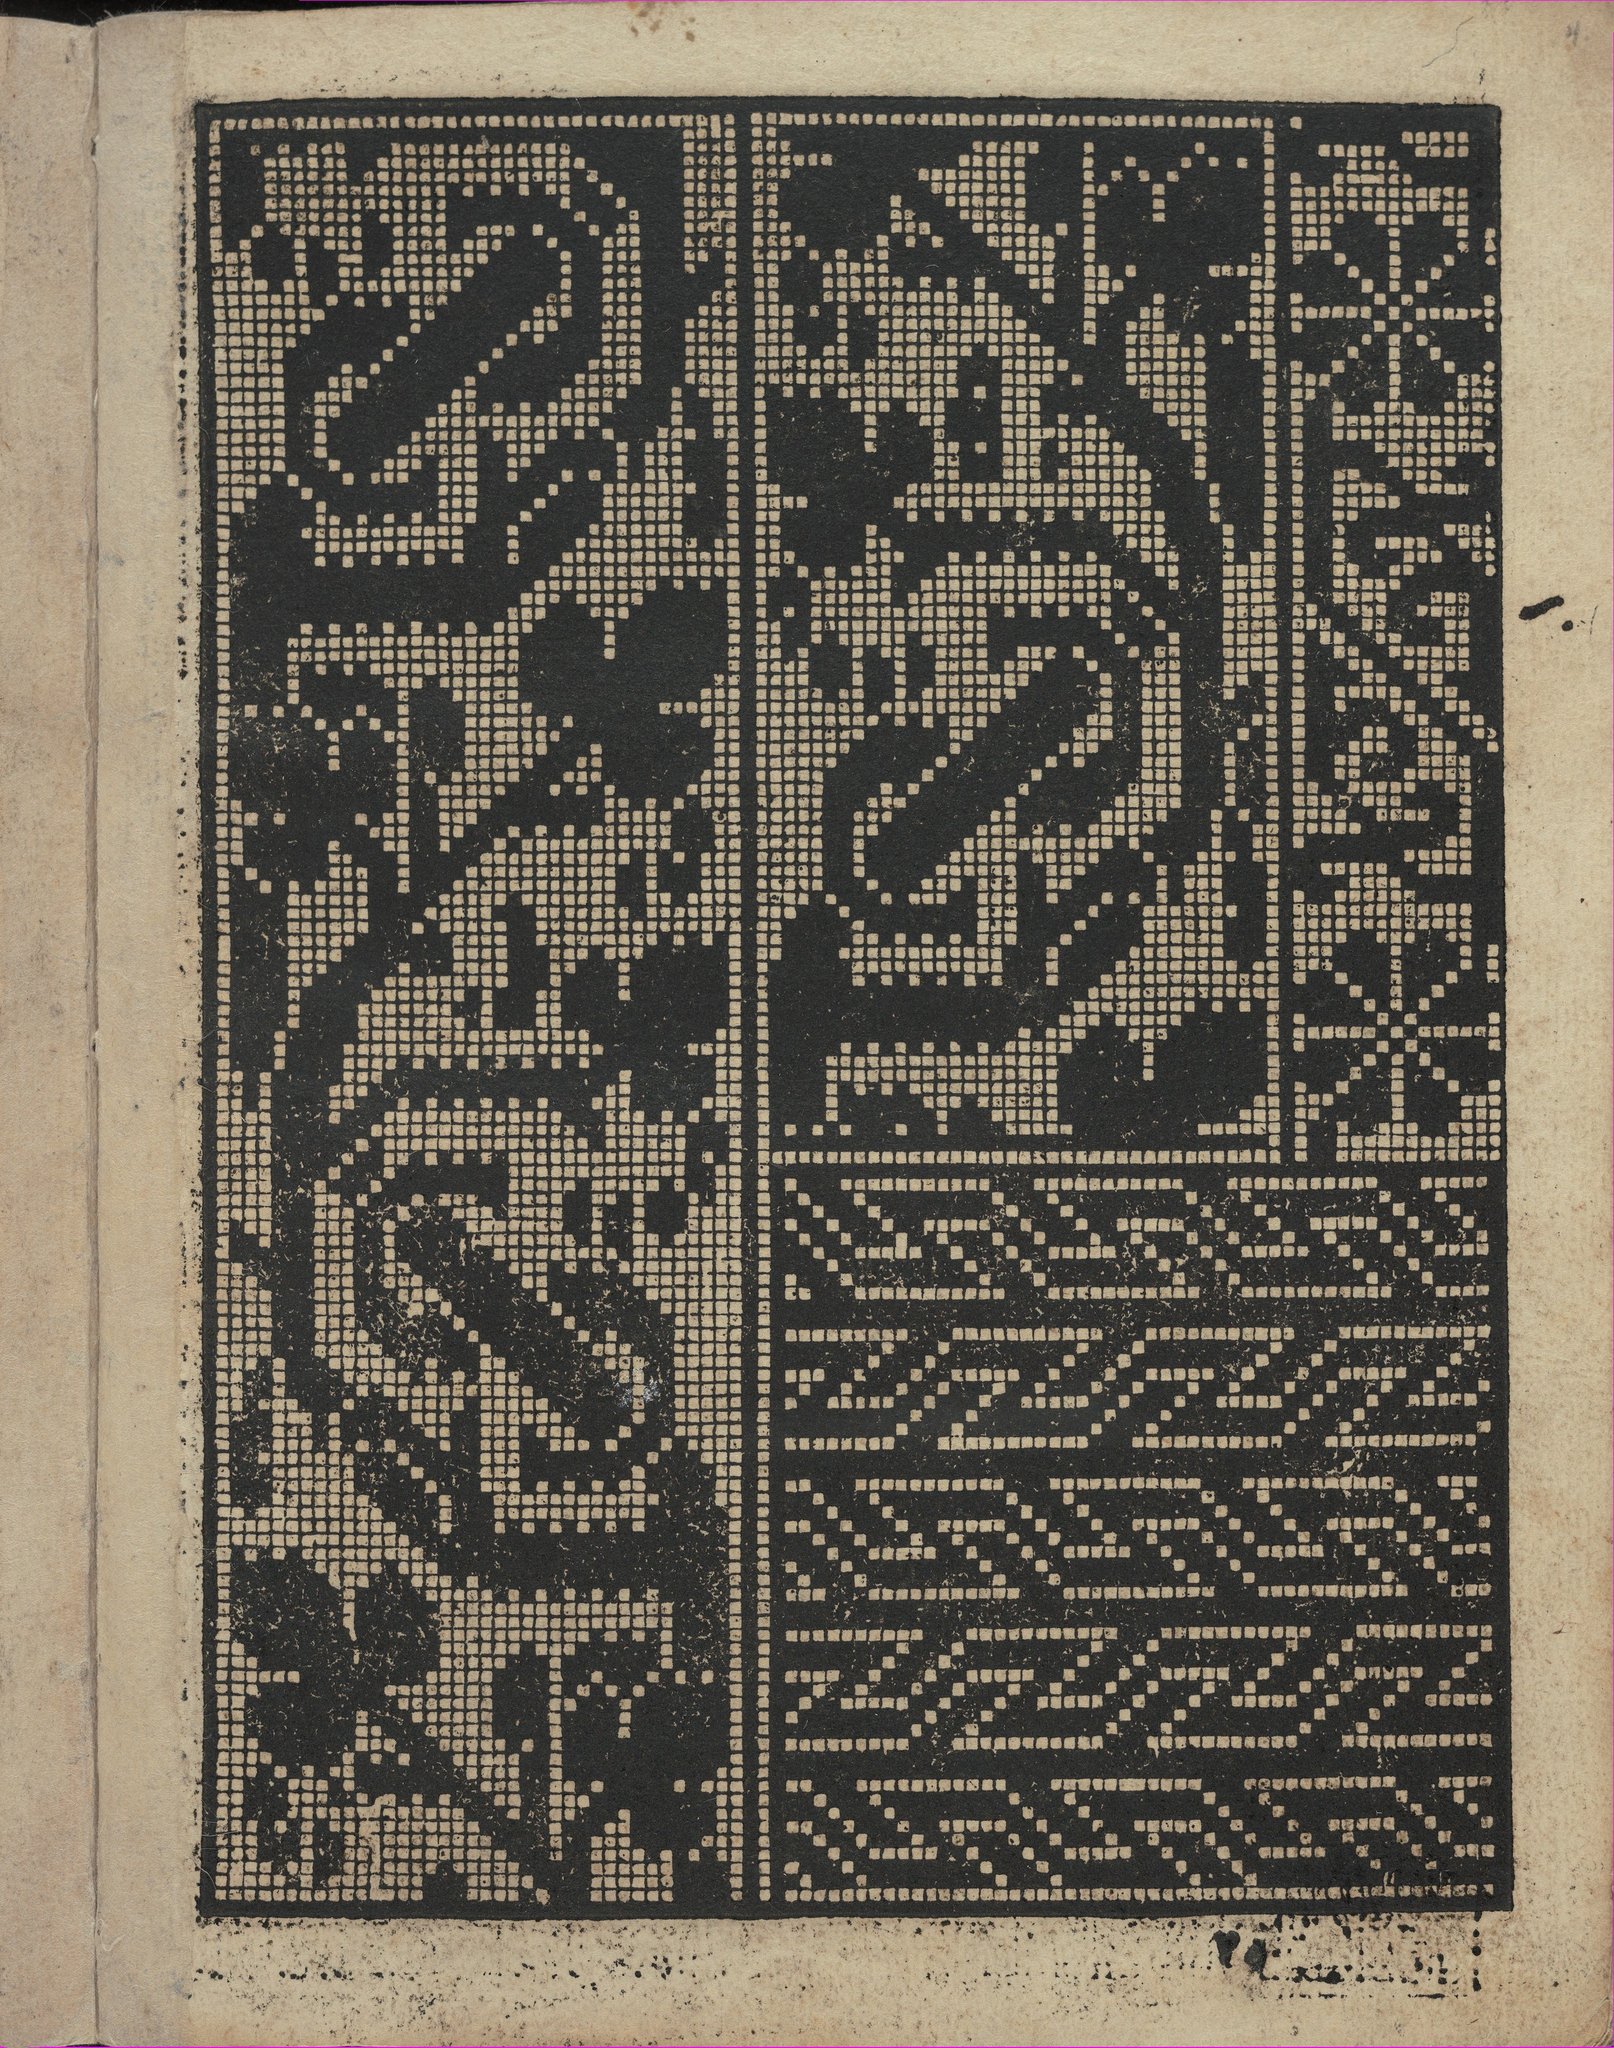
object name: book print ornament architecture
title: Libbretto nouellamete composto per maestro Domenico da Sera...lauorare di ogni sorte di punti, page 4 (recto)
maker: domenico da sera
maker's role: publisher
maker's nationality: french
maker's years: 1500-1599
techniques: woodcut